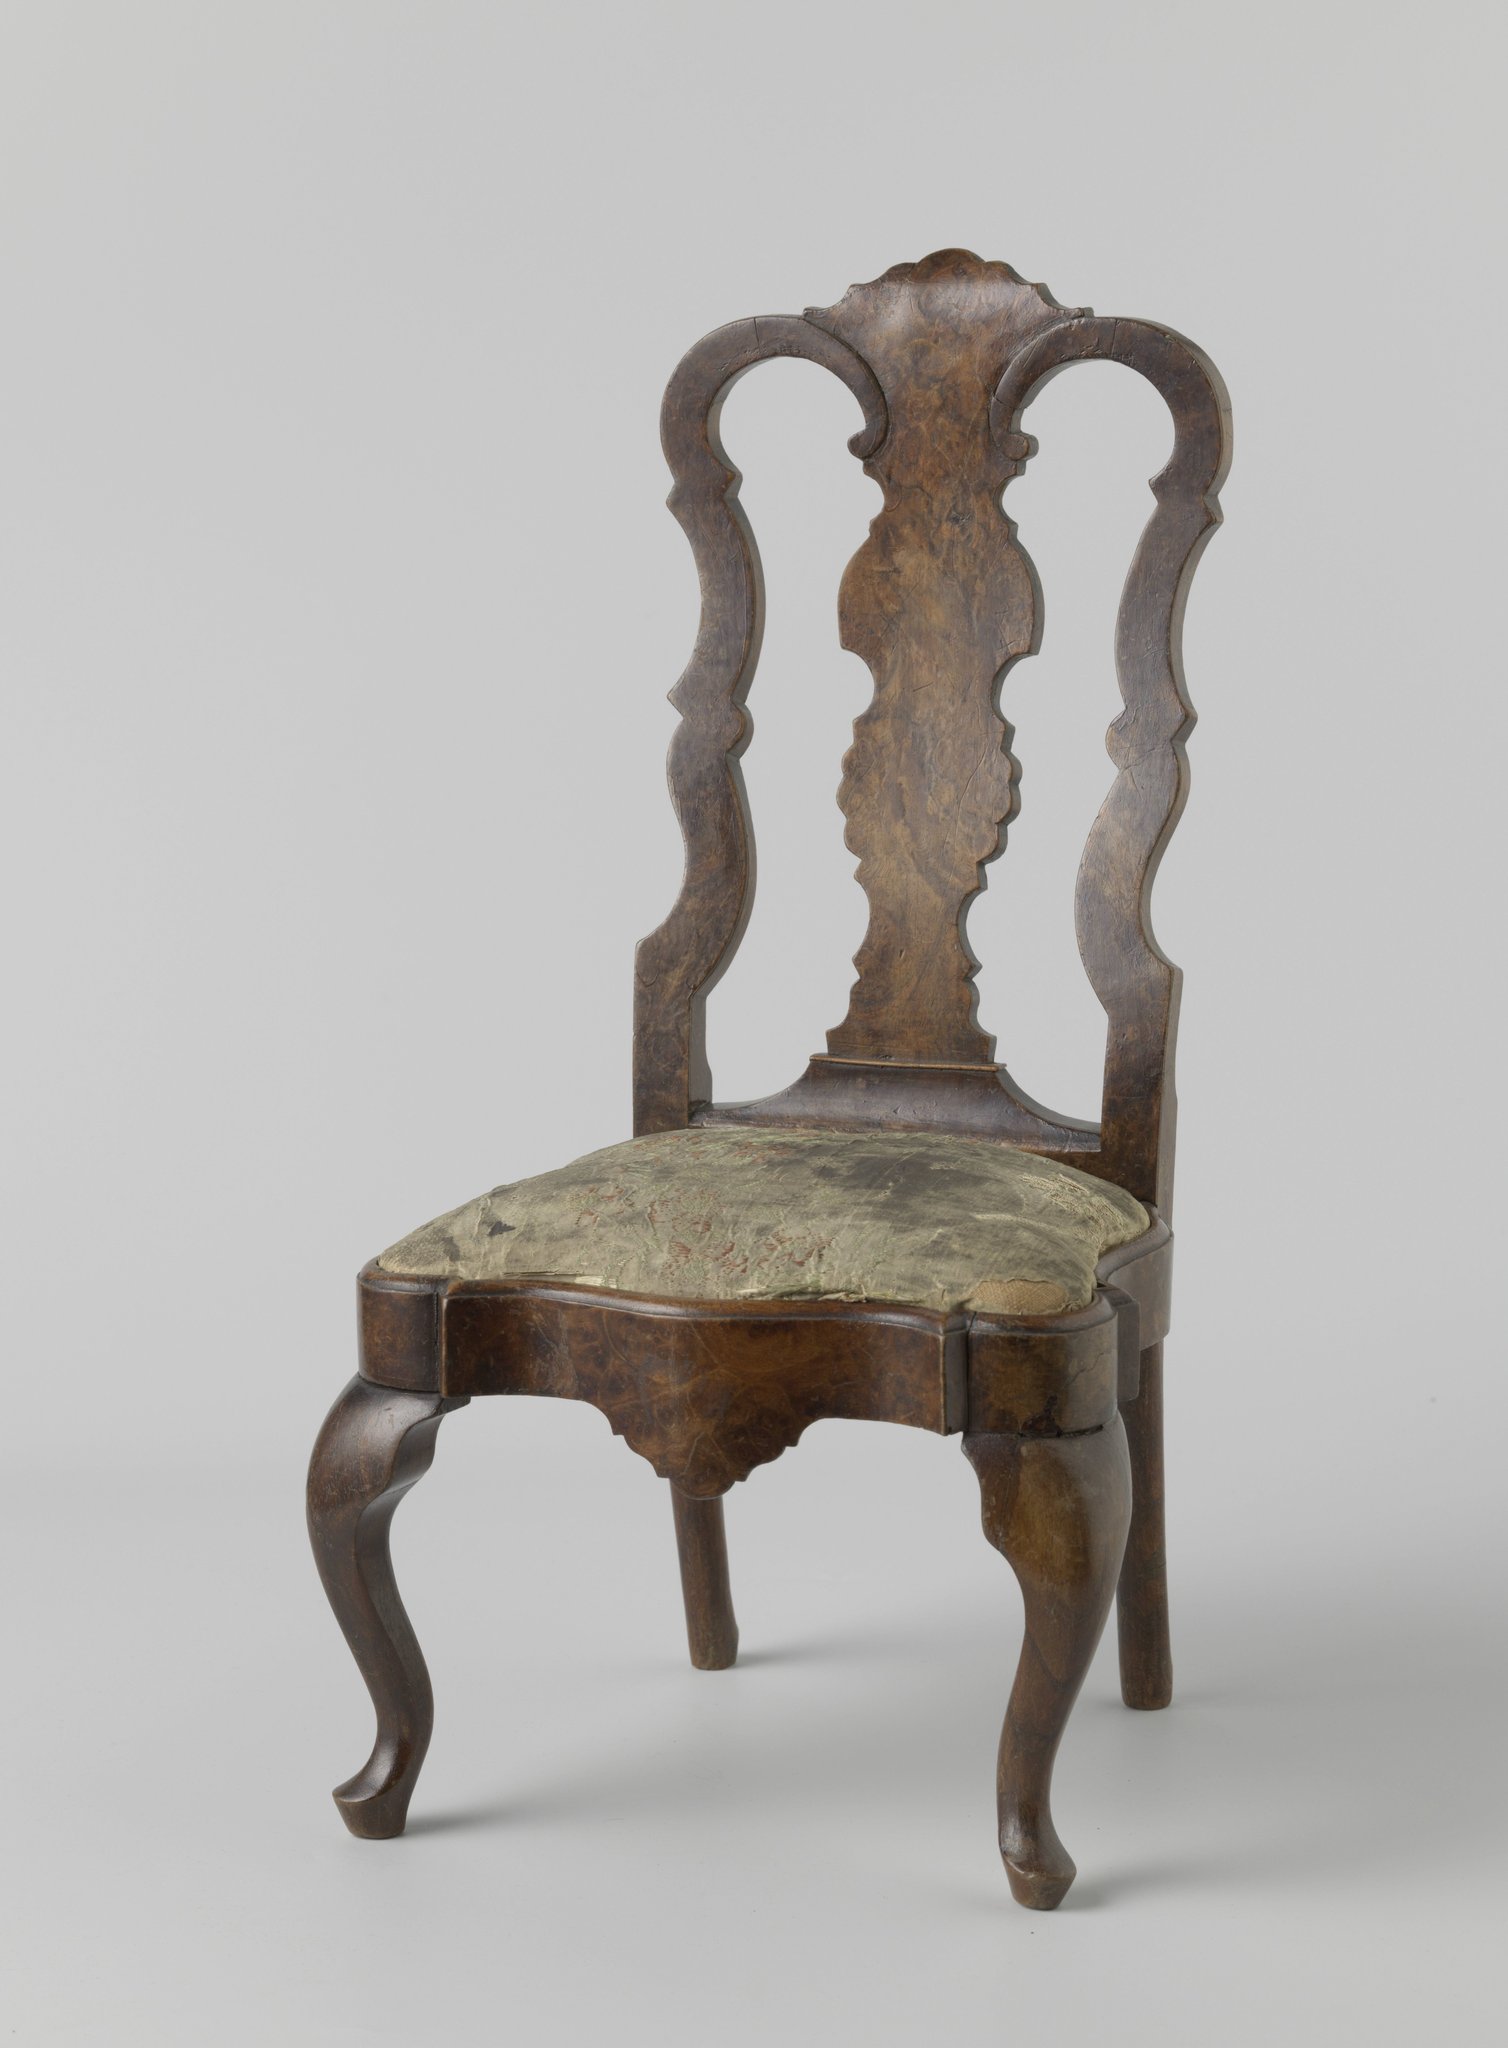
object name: furniture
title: Meubilair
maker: Anonymous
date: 1700-1750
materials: silk, wood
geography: northern netherlands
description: Stoel van notenhout. Het zitraam en de rug zijn aan de voorzijde belijmd met wortelnotenhout. Het zitraam is geschulpt en draagt een op raam gespannen los kussen met zijden bekleding. De stoel staat op gebogen poten. De lichtgeholde rug is plat en heeft een symmetrisch geschulpte omtrek.